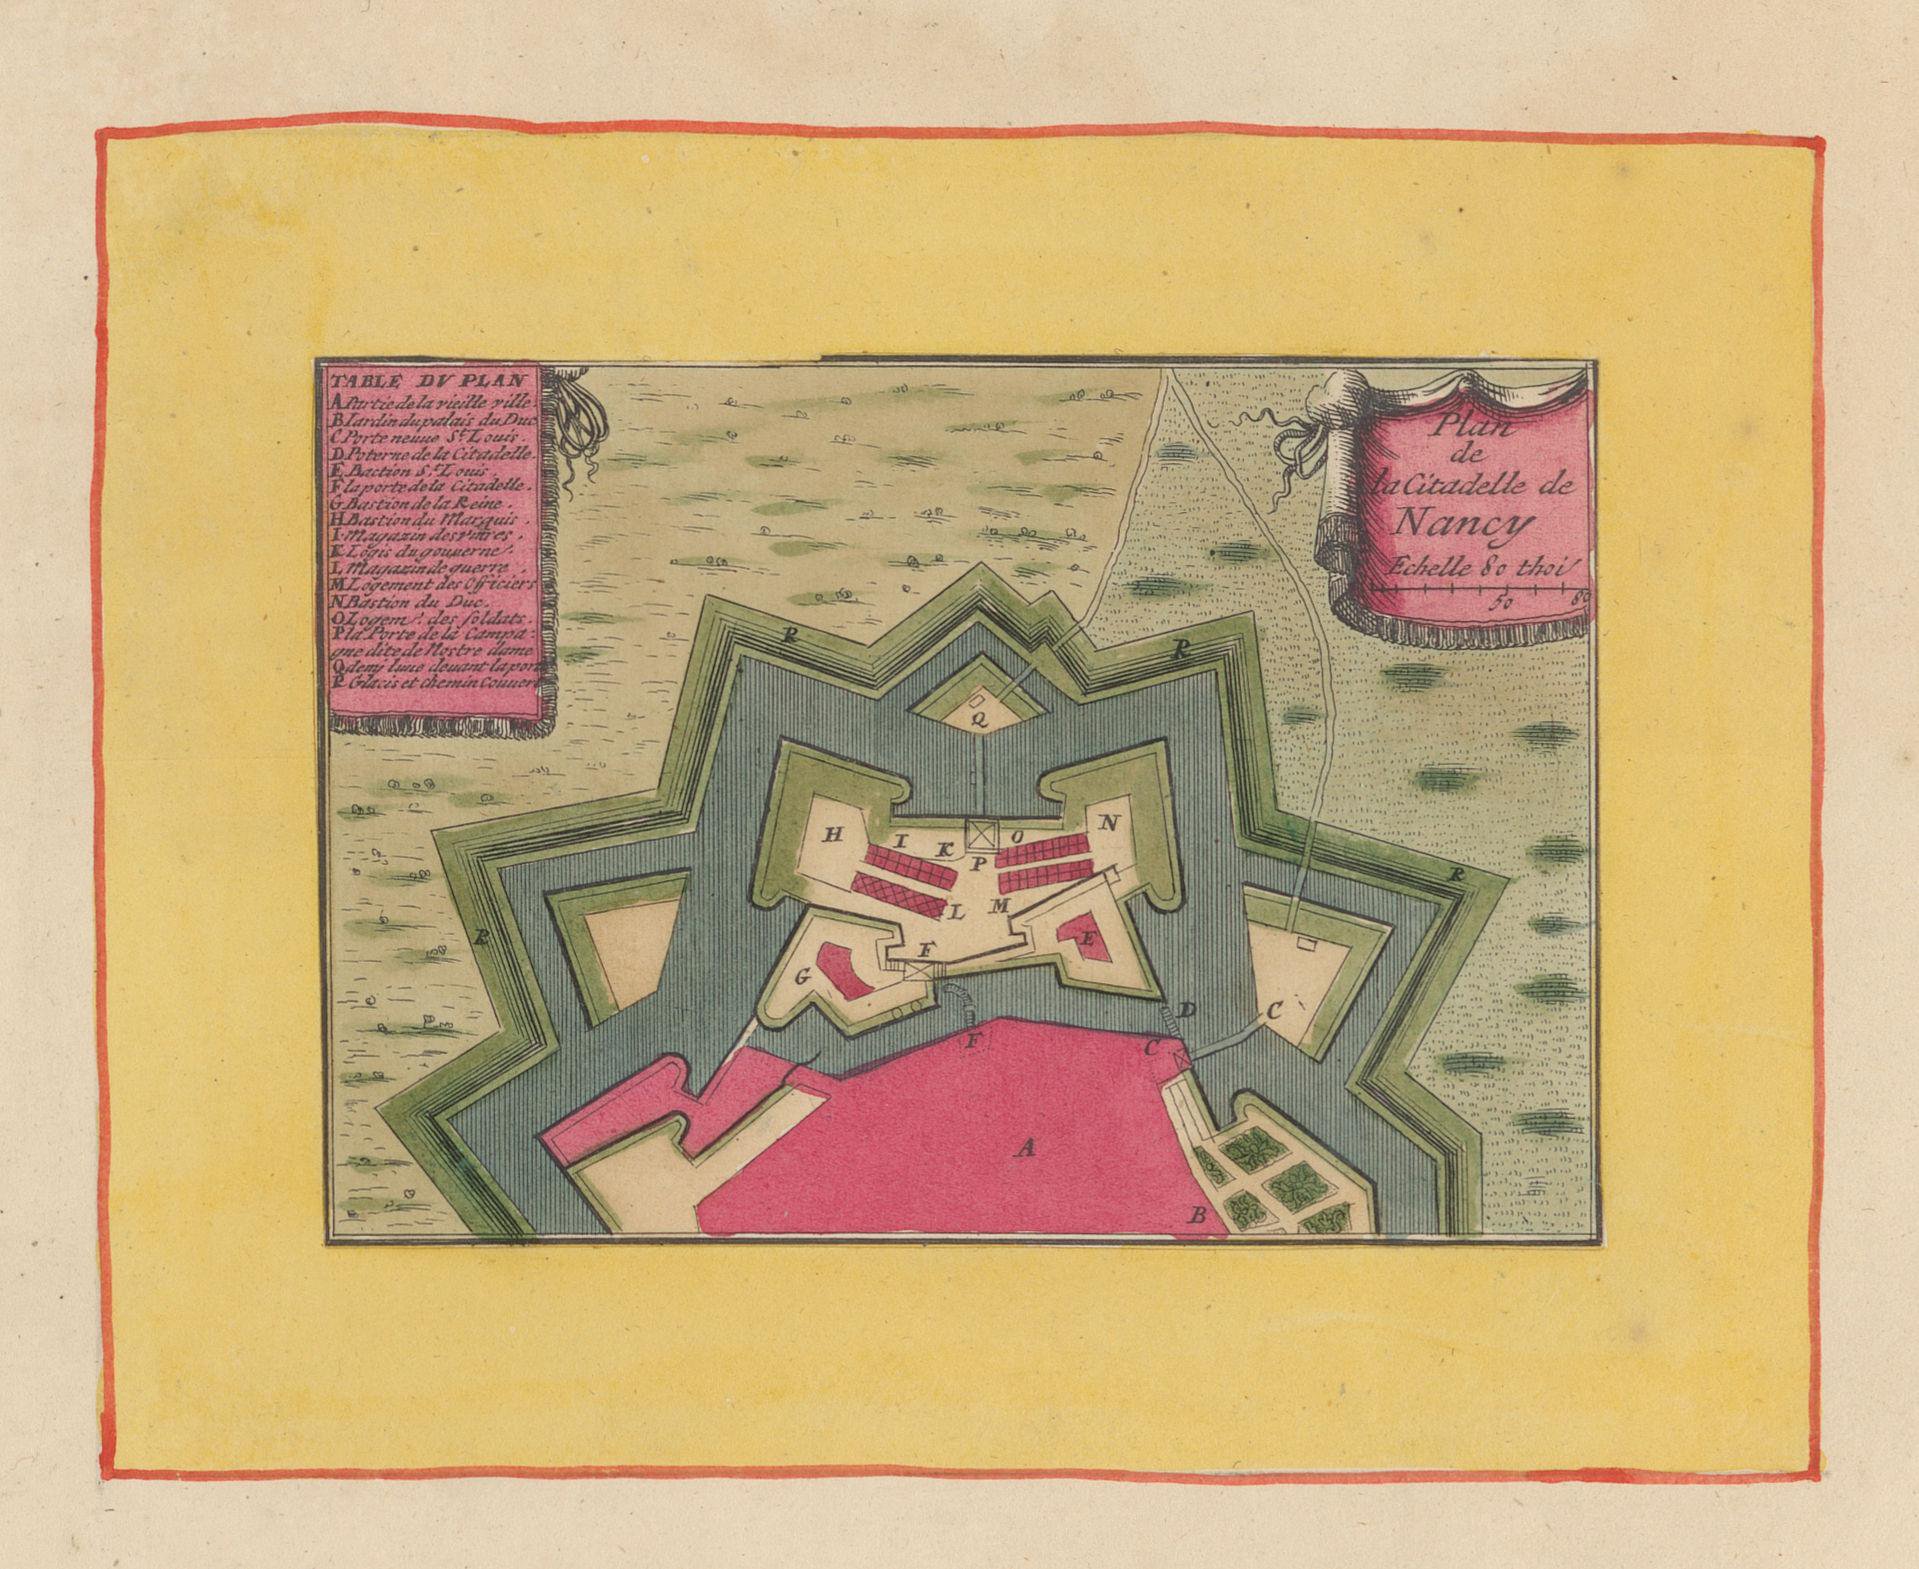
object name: print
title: Plan des villes et citadelle de Nancy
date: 1700-1702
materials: paper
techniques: engraving, hand coloring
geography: the hague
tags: maps of cities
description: Deze plattegrond is in meerdere atlassen gebruikt. Onder andere in: Les forces de l'Europe. 10 dln. Amsterdam: Pieter Mortier, ca. 1700. En in: Les forces de l'Europe. 12 dln. Amsterdam: Pieter Mortier, 1702. Door het ontbreken van de marges van deze prent is onduidelijk om welke staat het gaat. Derhalve is niet te bepalen uit welke van deze publicaties dit exemplaar komt. Later is deze zelfde prent door Pieter van der Aa gebruikt in twee publicaties. Gezien het eind van de werkzame periode van de inkleurder van de prenten in dit album is het niet mogelijk dat deze prent uit een van die publicaties komt.